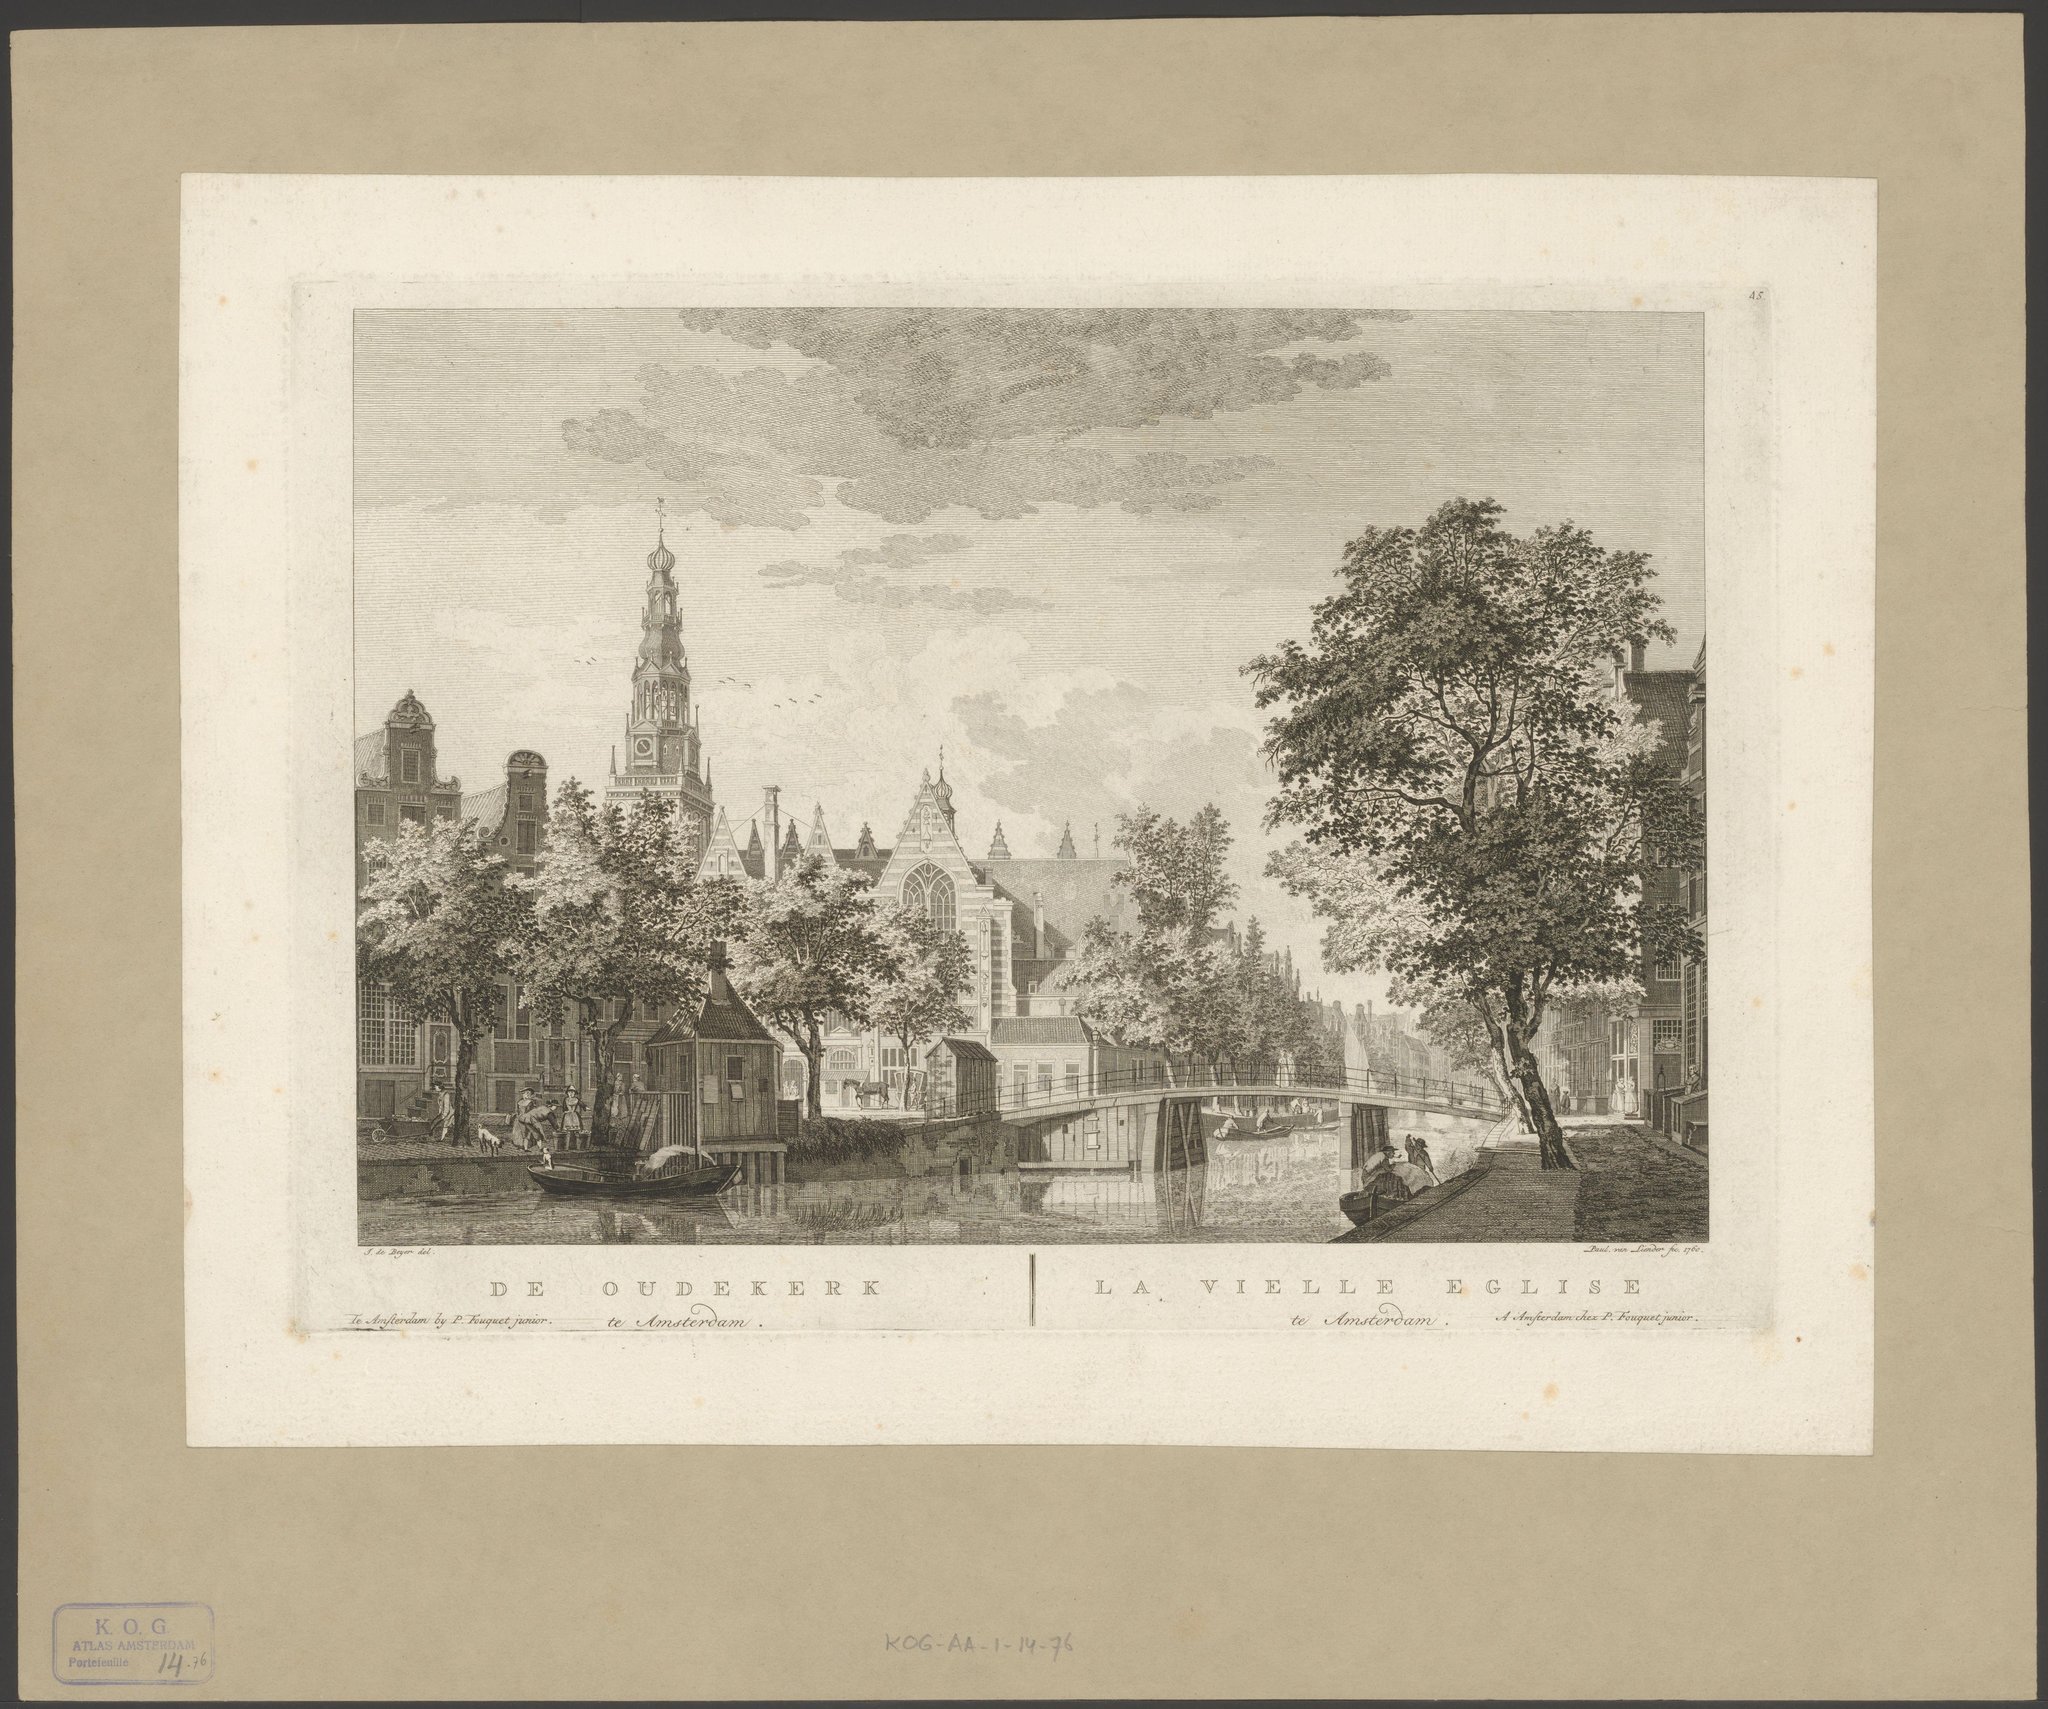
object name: print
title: Gezicht op de Oudezijds Voorburgwal met de Oude Kerk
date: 1788-1801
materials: paper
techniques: etching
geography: amsterdam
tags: city-view in general; 'veduta', canal, church (exterior), bridge in city across river, canal, etc., street, boat propelled by man or animal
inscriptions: collector's mark: ‘14.76’ Lugt 1641b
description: Deze prent is ook gebruikt in de zogenaamde Atlas van Fouquet.* Pierre Fouquet gaf vanaf 1760 stadsgezichten van Amsterdam - naar tekeningen van verschillende kunstenaars, gemaakt door verschillende prentmakers - uit. Deze prenten werden aanvankelijk los of in series verkocht. Zoals toen gebruikelijk kon de koper de prenten zelf laten inbinden. Hiertoe gaf Fouquet tussen 1778 en 1783 een titelblad, plattegrond en inhoudsopgave van de tot dusver 100 uitgegeven prenten uit (1). Gezien de inhoud afhankelijk was van wat de koper had verzameld verschilt de inhoud van de verschillende bewaarde Fouquetatlassen onder deze titel sterk. Ook zijn er exemplaren bekend waar tevens andere prenten aan zijn toegevoegd. Omdat er behoefte bleek aan uitleg bij de platen werd in 1783 een nieuwe versie van de atlas uitgegeven, aangevuld met tekst en twee prenten. De aangegeven volgorde veranderde maar de platen van de al eerder uitgegeven prenten bleven ongewijzigd. Deze uitgave werd in opdracht van Fouquet gedrukt bij Daniël Jean Changuion en Petrus den Hengst (2). Een tiental platen werd bijgewerkt en verscheen, met nieuw impressum, in het vervolg van Wagenaars geschiedenis van Amsterdam, uitgeven door Petrus Conradi en Folkert van der Plaats (3). Een aantal jaar na het overlijden van Fouquet kwam Evert Maaskamp met een nieuwe uitgave van de atlas, met verbeterde tekst en toevoeging van twee prenten. Op alle platen verwijderde hij het oude en liet hij zijn eigen impressum zetten (4). De huidige staat van de prent komt voor in exemplaren van de onder (3) genoemde werken. * Onder de Atlas van Fouquet of Fouquetatlas verstaan we de hieronder vermelde publicaties (1), (2) en (4). (1). Afbeeldingen van de wyd-vermaarde koopstad Amsterdam benevens des zelvs voornaamste gebouwen en gezigten alle naar het leeven getekend / Receuil des edifices les plus considerables et des plus belles vues, de la fameuse ville d'Amsterdam, dessinées d'après nature. Amsterdam: Pierre Fouquet, 1778-1783. (2). Nieuwe atlas, van de voornaamste gebouwen en gezigten der stad Amsterdam, met derzelver beknopte beschryvingen. 2 delen. Amsterdam: Daniël Jean Changuion en Petrus den Hengst [in opdracht van Pierre Fouquet], 1783. (3). Stijl, Simon. Amsterdam, in zyne geschiedenissen, voorregten, koophandel, gebouwen, kerkenstaat, schoolen, schutterye, gilden en regeeringe, beschreeven. Om te dienen ten vervolge op het werk van Jan Wagenaar (…). 10 delen. Amsterdam en Harlingen: Petrus Conradi en Folkert van der Plaats, 1788-1801. (4). Nieuwe atlas, van de voornaamste gebouwen en gezigten der stad Amsterdam. Met derzelver beknopte beschryvingen. Amsterdam: Evert Maaskamp, 1805. * Het aantal vermelde staten is gebaseerd op het aantal gevonden staten. Mogelijk zijn er meer staten van deze prent.